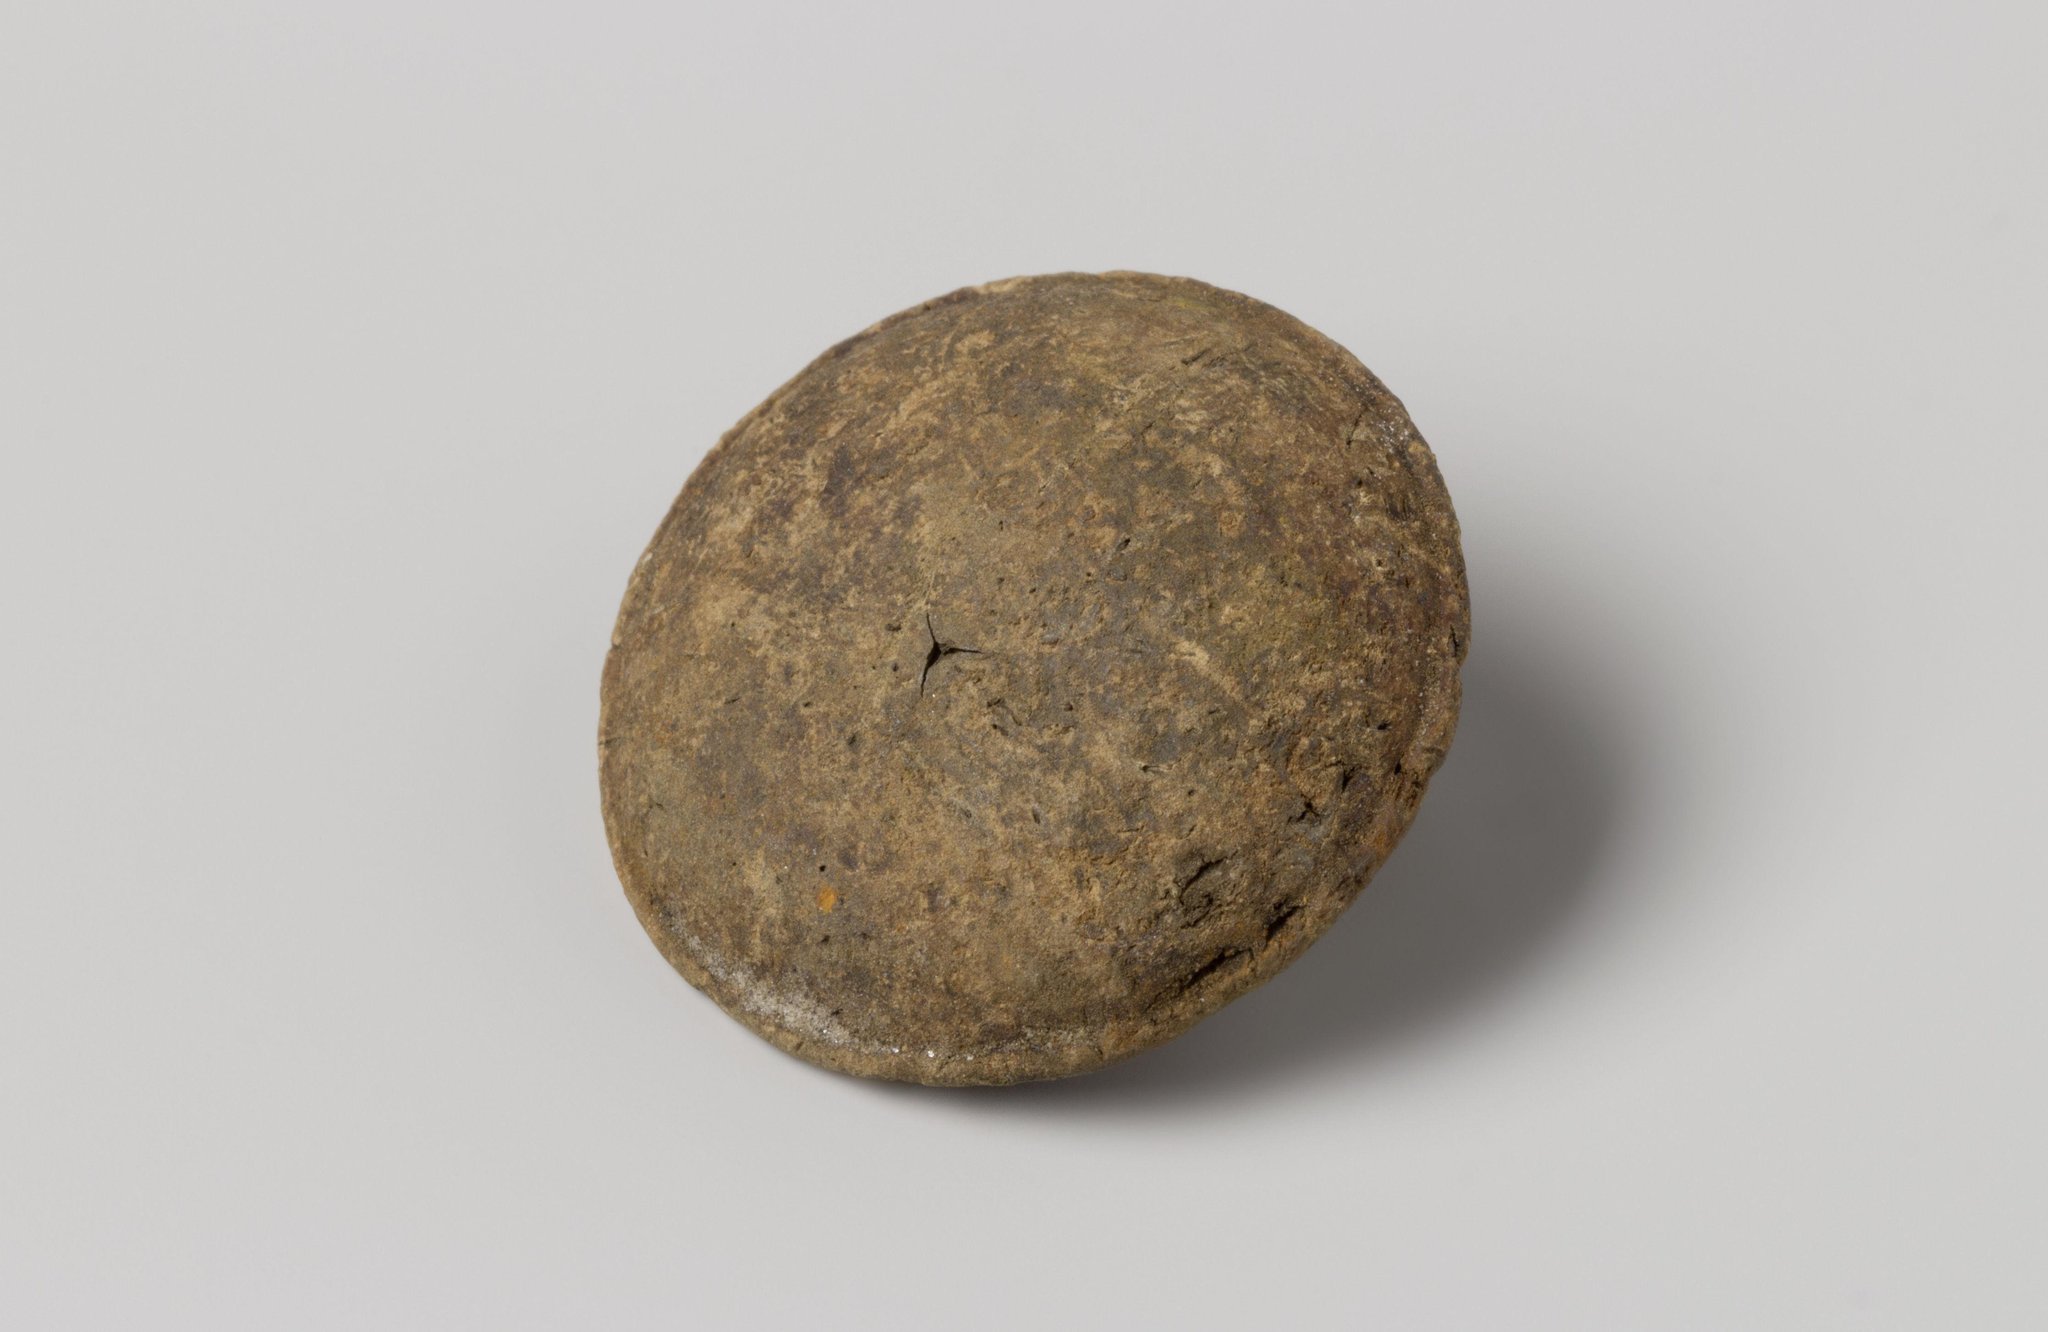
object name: button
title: Knoop uit het wrak van de Oost-Indiëvaarder Hollandia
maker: Anonymous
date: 1700-1743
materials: bone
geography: netherlands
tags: verenigde oostindische compagnie, hollandia (schip), annet